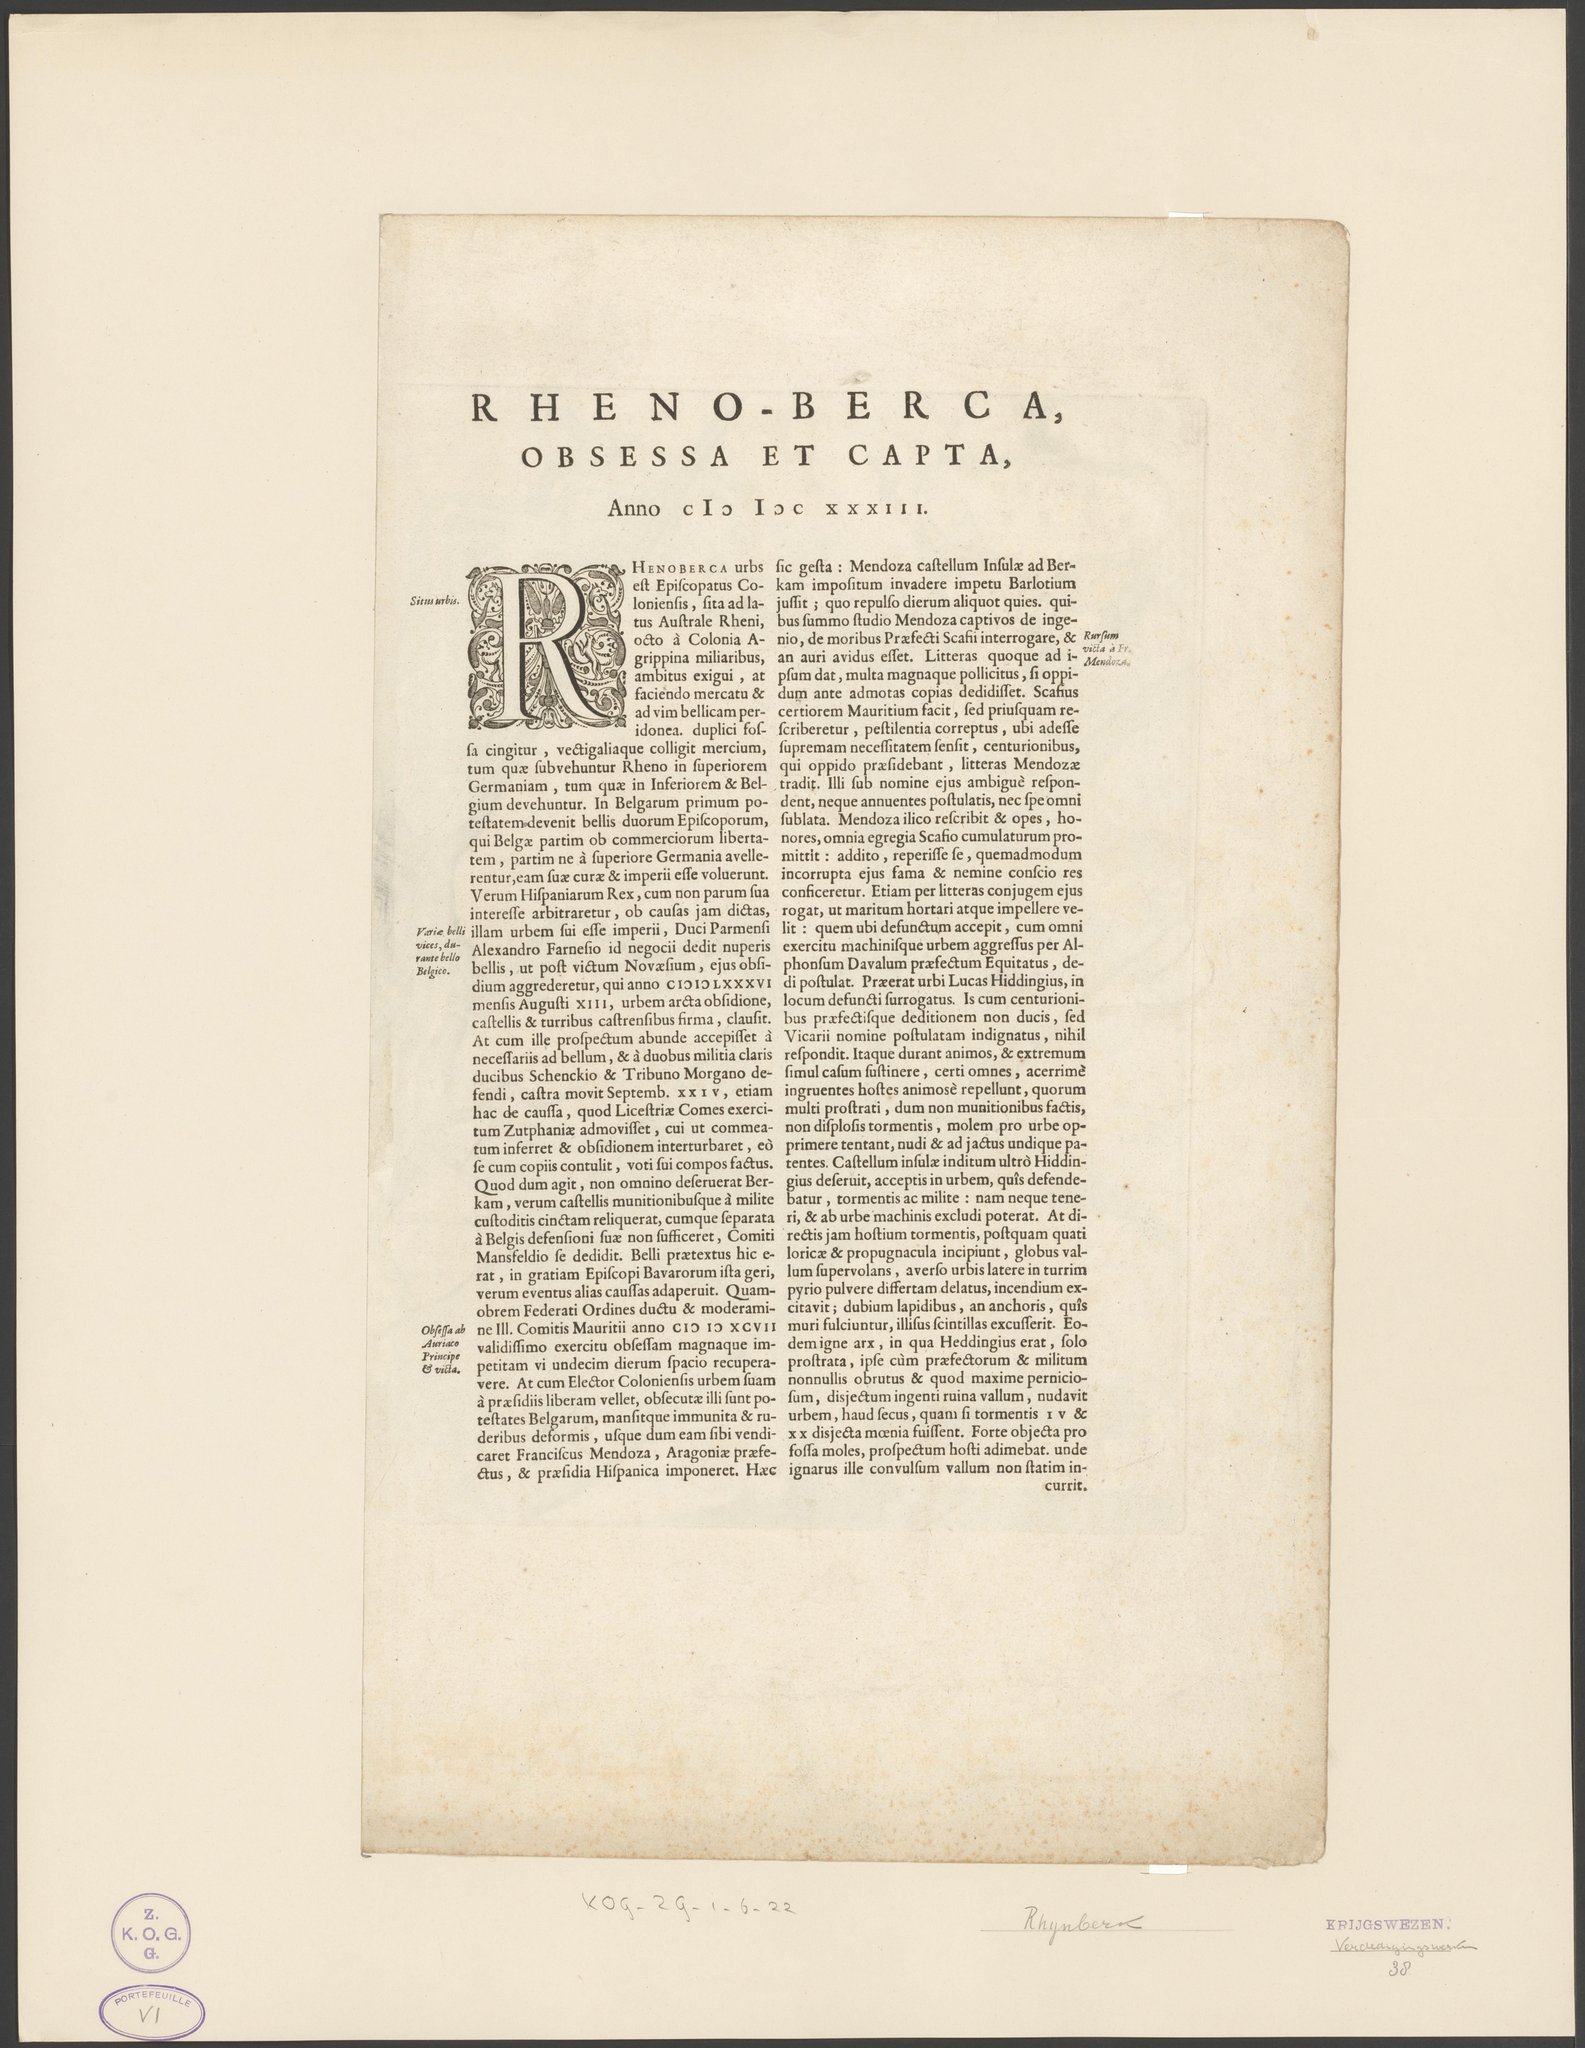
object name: print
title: Plattegrond van Rijnberg, 1633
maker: Anonymous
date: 1647-1649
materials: paper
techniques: engraving, etching, letterpress printing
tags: fortress, maps of cities, siege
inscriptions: stamp, collector's mark: Lugt 1641, stamp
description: Plattegrond van Rijnberg, belegerd en ingenomen door het Staatse leger onder Frederik Hendrik, 16 mei - 2 juni 1633. Plan van de vestingwerken om de stad. Op een dubbelblad genomen uit het Stedenboek van Blaeu. Bedrukt op achterzijde met tekst in het Latijn. Onderwerpsrubrieken binnen de Atlas Zeden en Gewoonten: Krijgswezen, Verdedigingswerken.